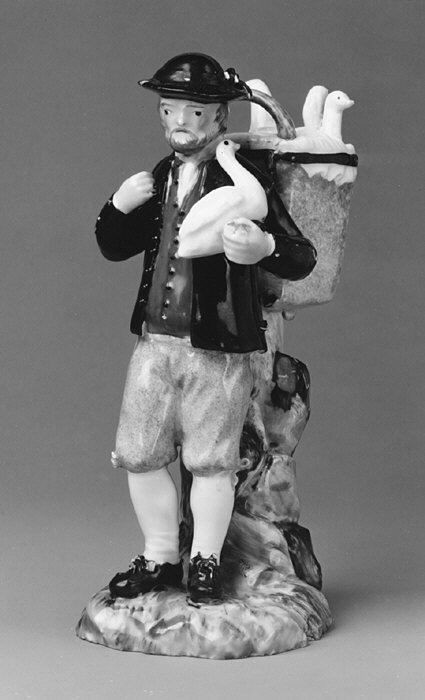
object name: figure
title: Goose Seller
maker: royal porcelain manufactory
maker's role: factory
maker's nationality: danish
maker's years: 1775-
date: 1780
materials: hard paste porcelain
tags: birds,men,working